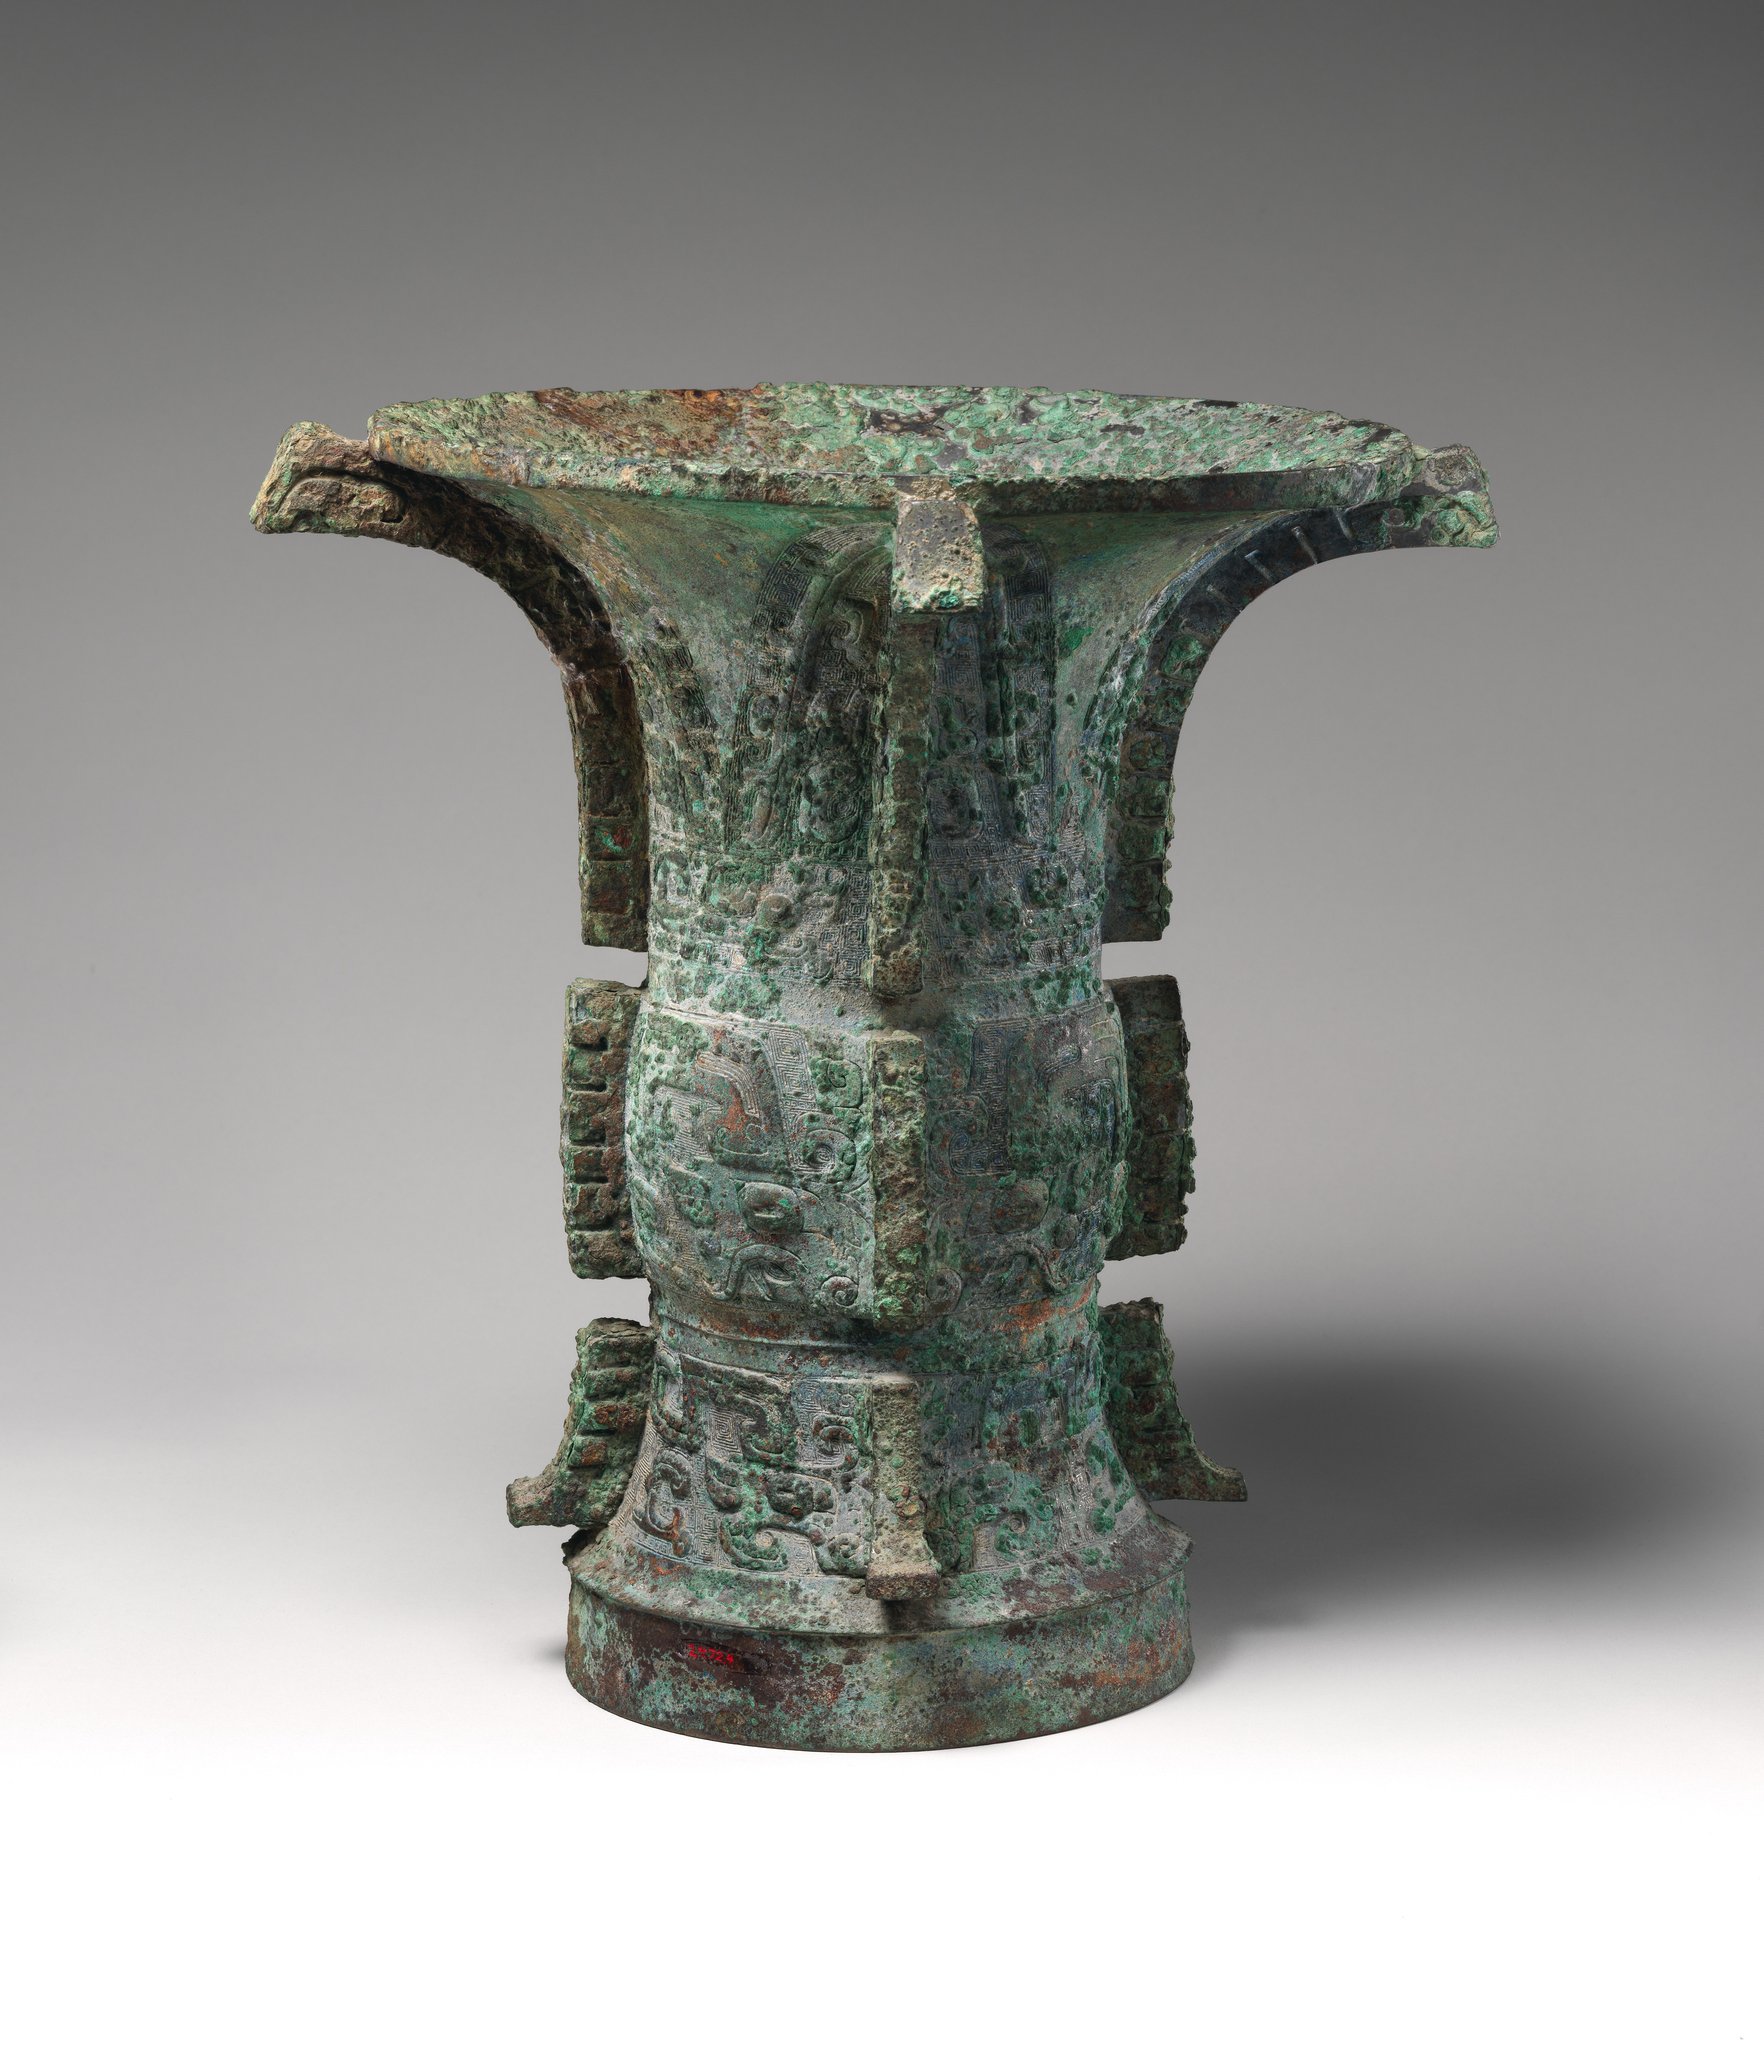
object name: wine container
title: Ritual wine container (zun)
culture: chinese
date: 1034-1001 BCE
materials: bronze